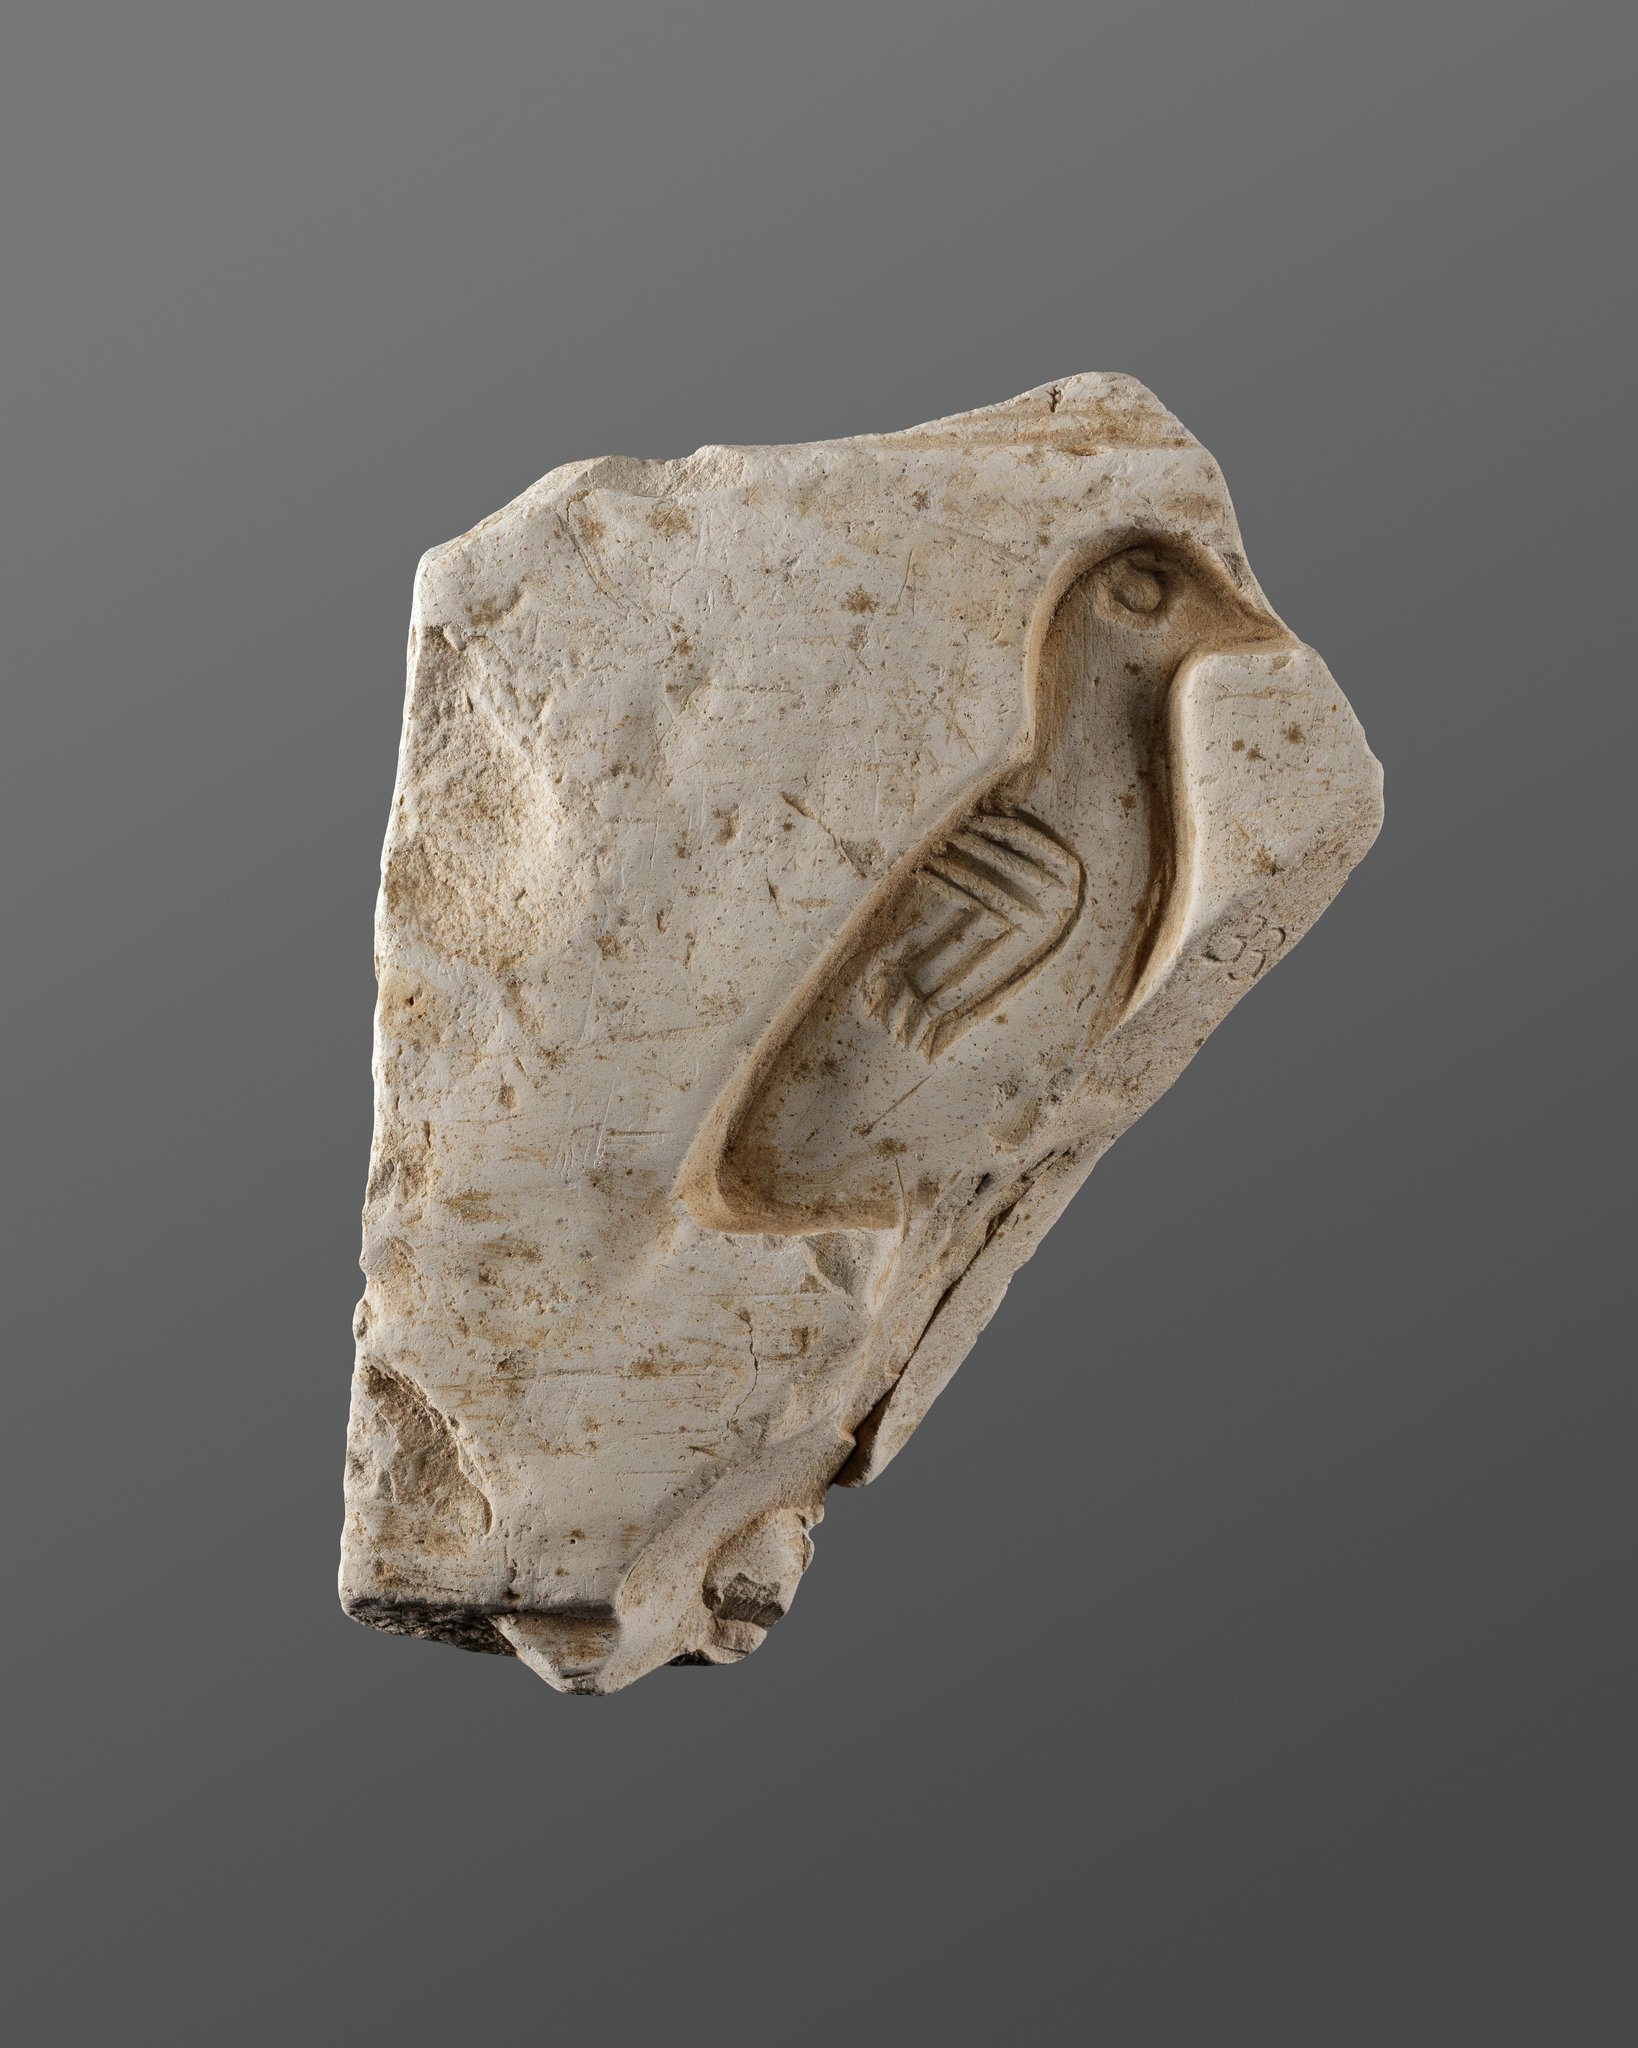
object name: relief fragment 47, tomb of mereri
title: Relief fragment possibly from the tomb of Mereri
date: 2100-2090 BCE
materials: stone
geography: egypt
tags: birds